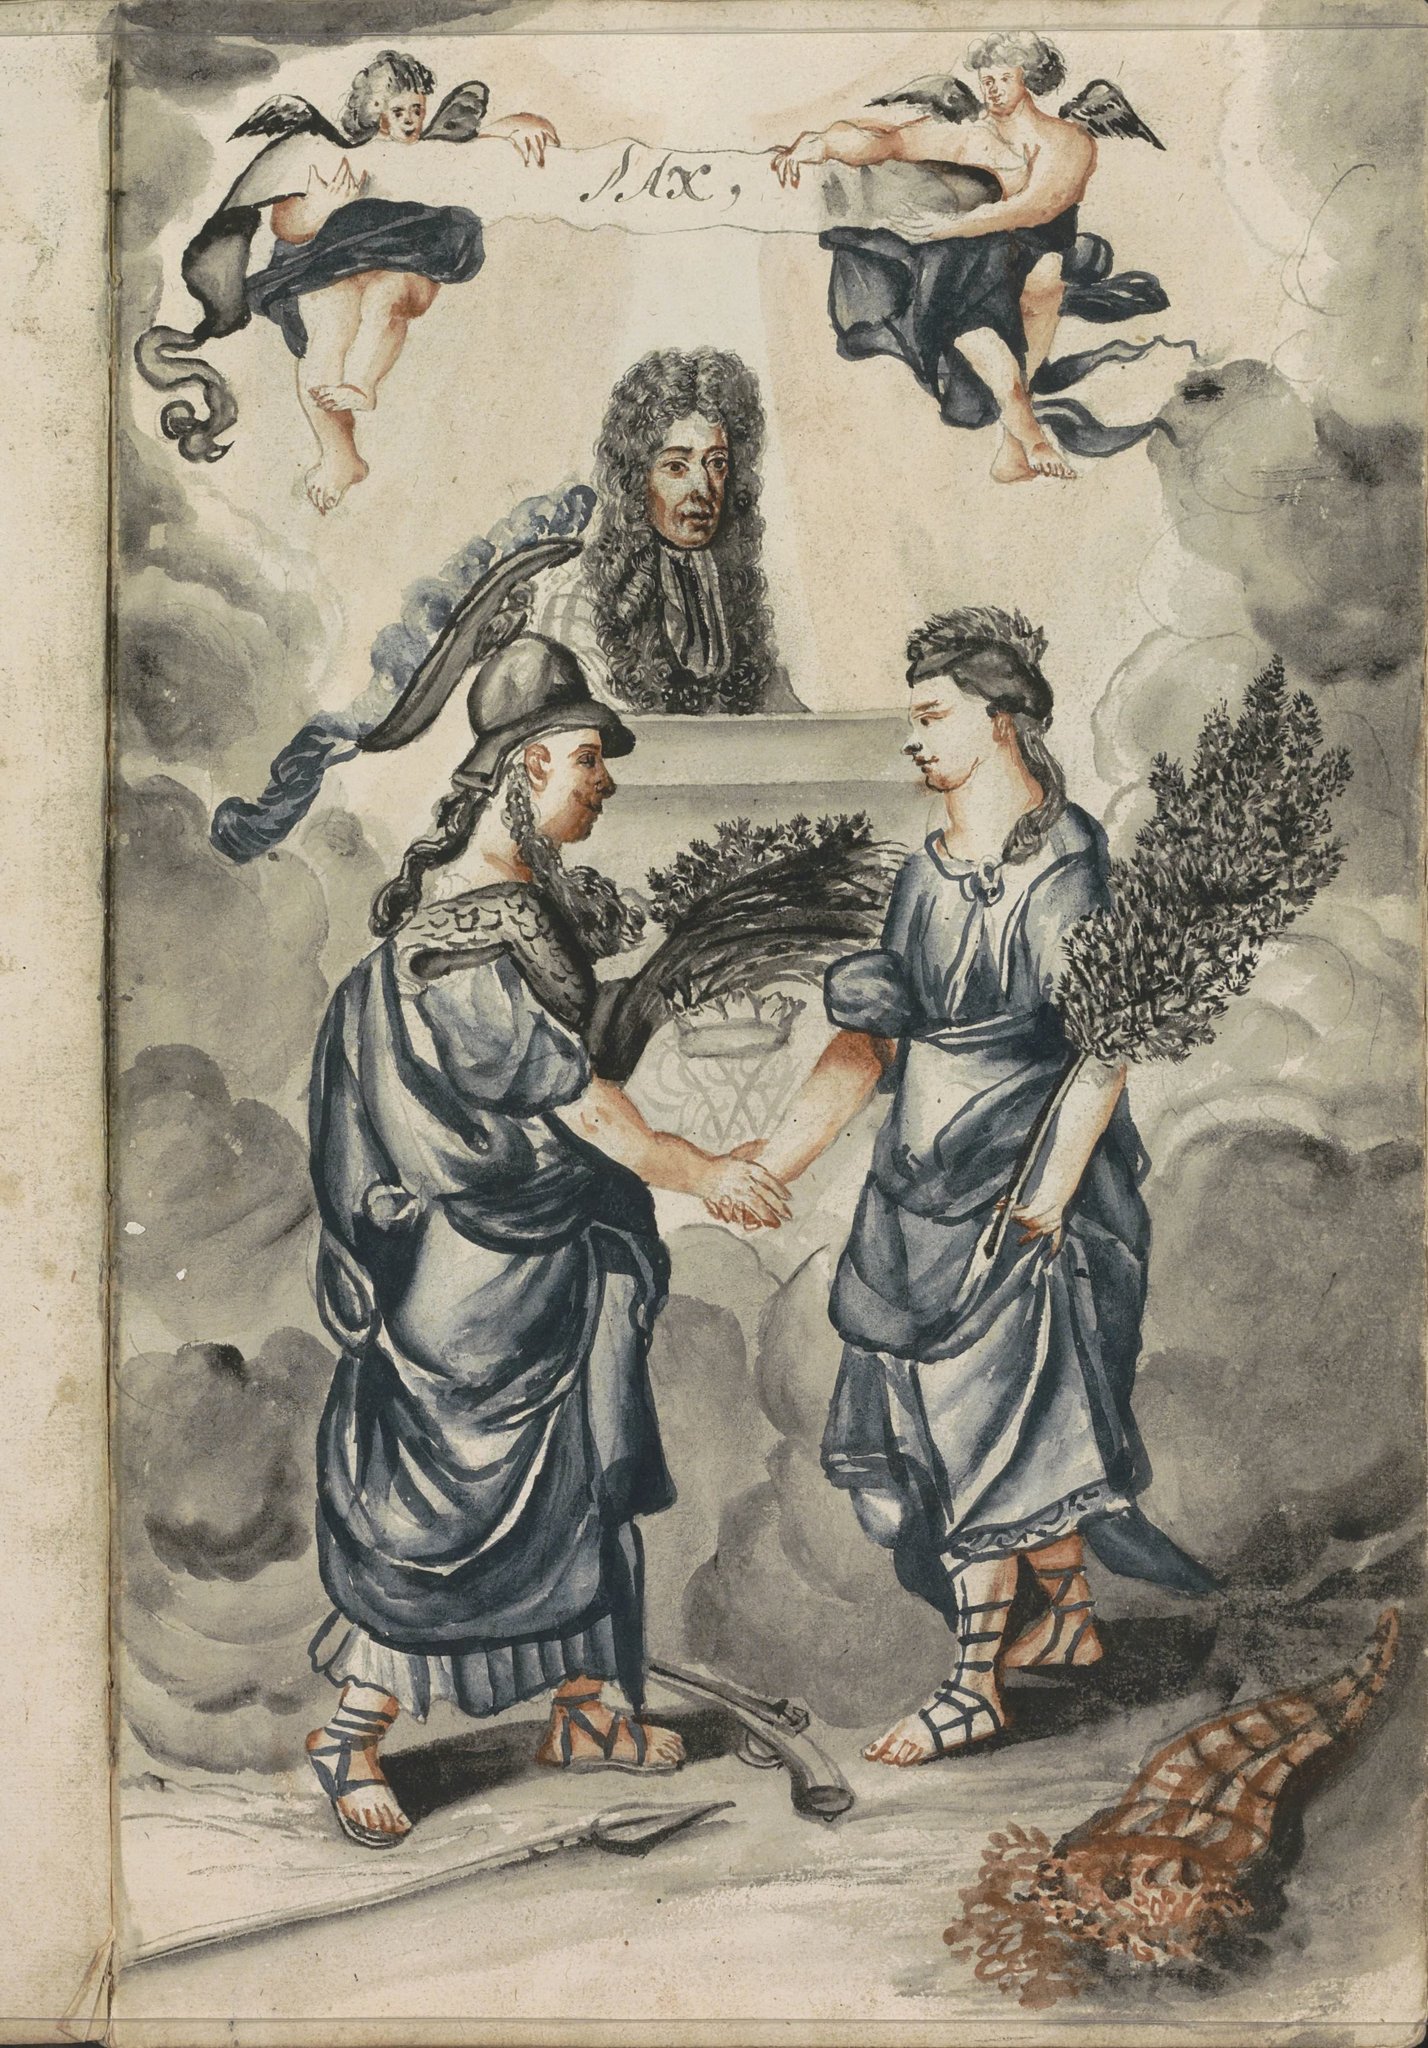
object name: sketchbook leaf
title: Willem III overziet het verbond tussen Wijsheid en Vrede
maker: hendrick van beaumont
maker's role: draughtsman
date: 1696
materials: paper, watercolor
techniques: brush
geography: northern netherlands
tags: the hague, william iii (prince of orange and king of england, scotland, and ireland), symbols, allegories of peace, 'pax'; 'pace' (ripa), 'sapientia', wisdom; 'sapienza divina' (ripa) ~ one of the seven gifts of the holy ghost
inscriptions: annotation: ‘PAX’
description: Blad 43 recto uit een schetsboek met 91 bladen.